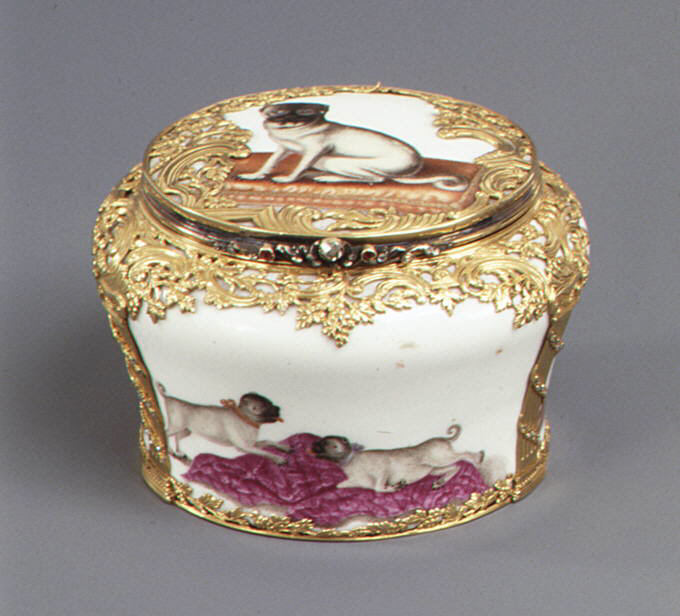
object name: snuffbox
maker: meissen manufactory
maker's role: manufactory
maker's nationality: german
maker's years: 1710-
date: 1760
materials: diamond, gold, hard paste porcelain, gemstone, silver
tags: dogs